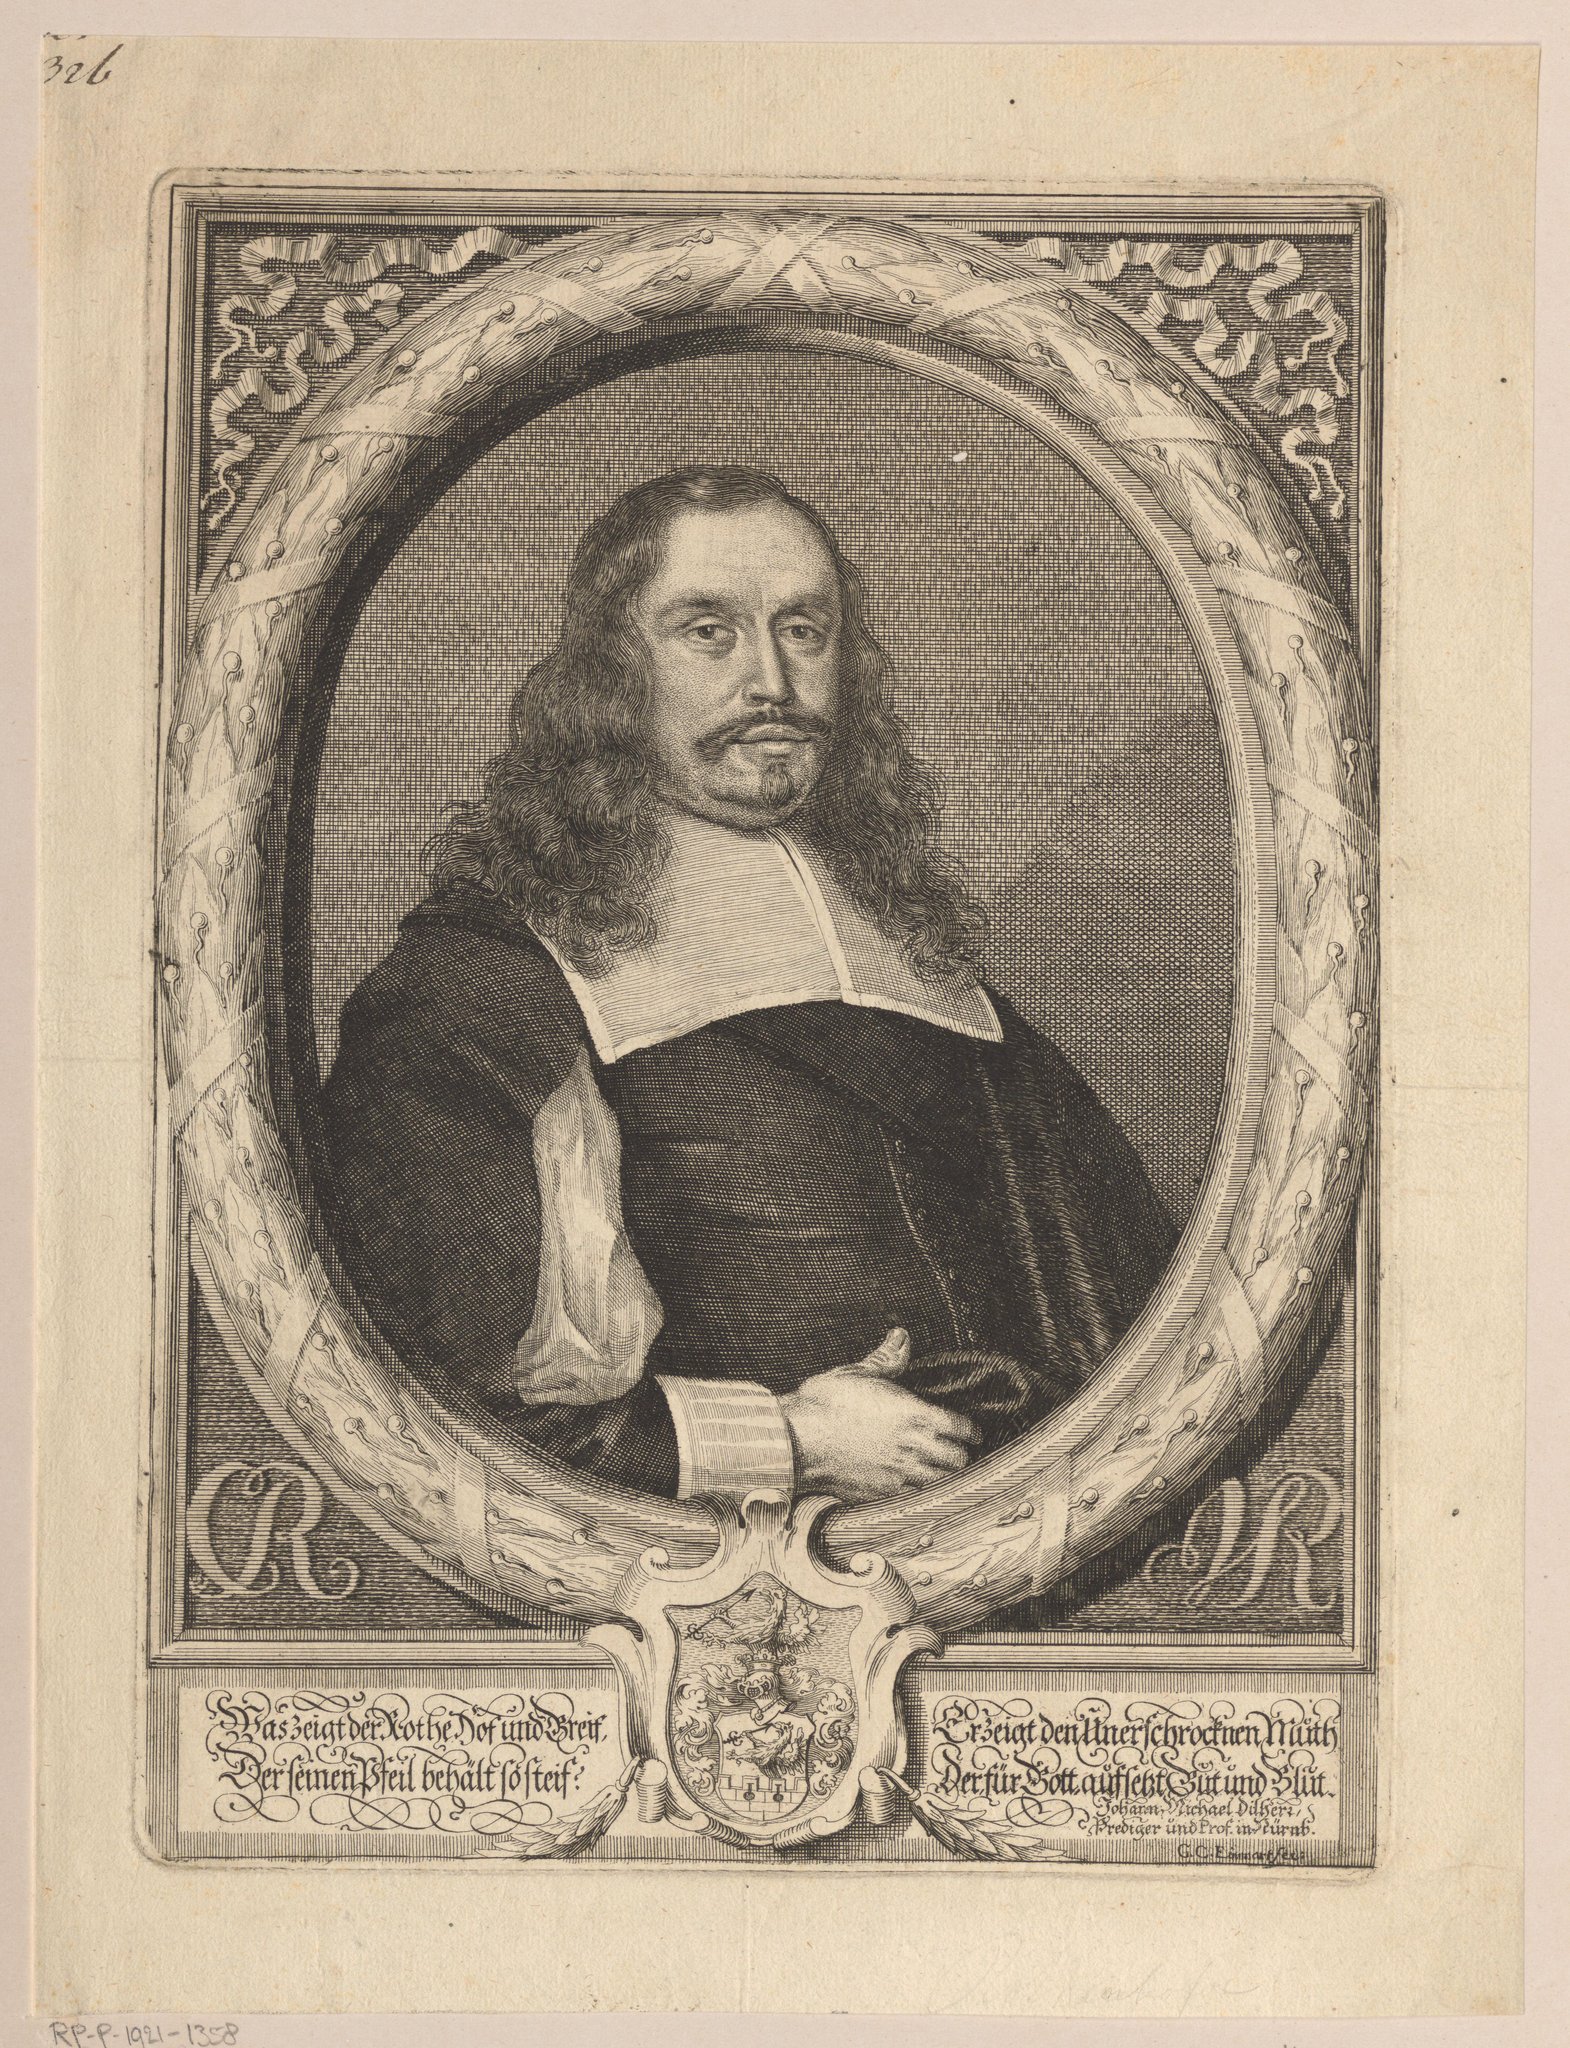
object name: print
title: Portret van Christoph Rothenhofer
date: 1648-1705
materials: paper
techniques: etching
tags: historical persons, armorial bearing, heraldry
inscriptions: collector's mark: Lugt 2233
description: Onder het portret zijn wapenschild. Onder het portret een vierregelig vers.